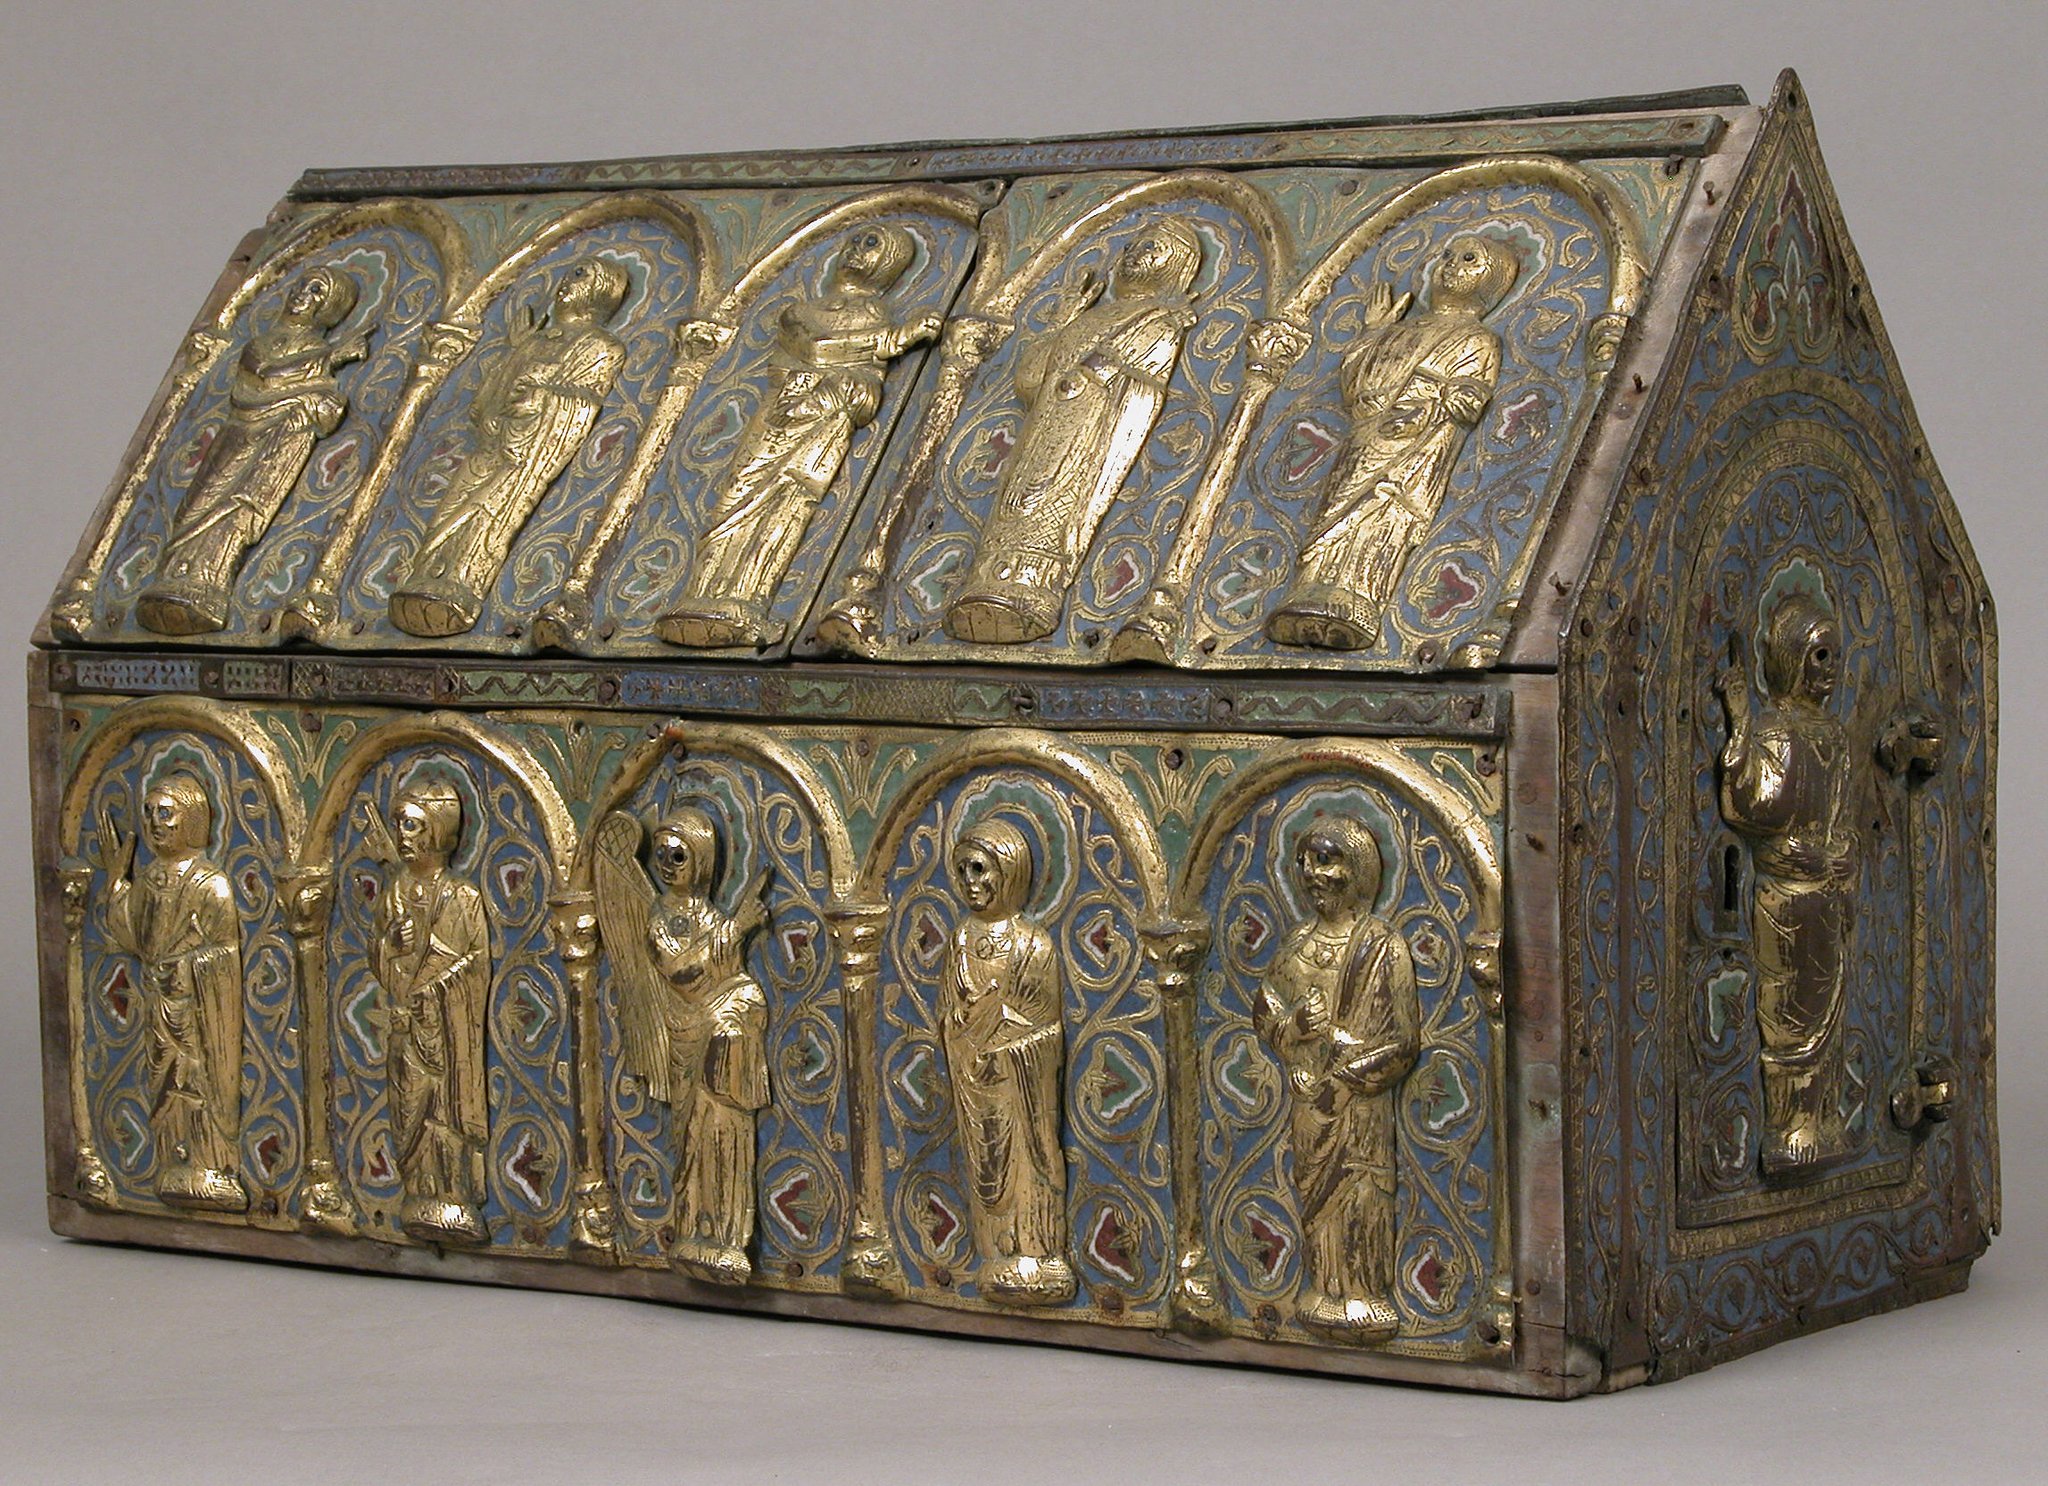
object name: chasse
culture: french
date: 1201-1300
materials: enamel, copper gilt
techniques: enamel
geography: france